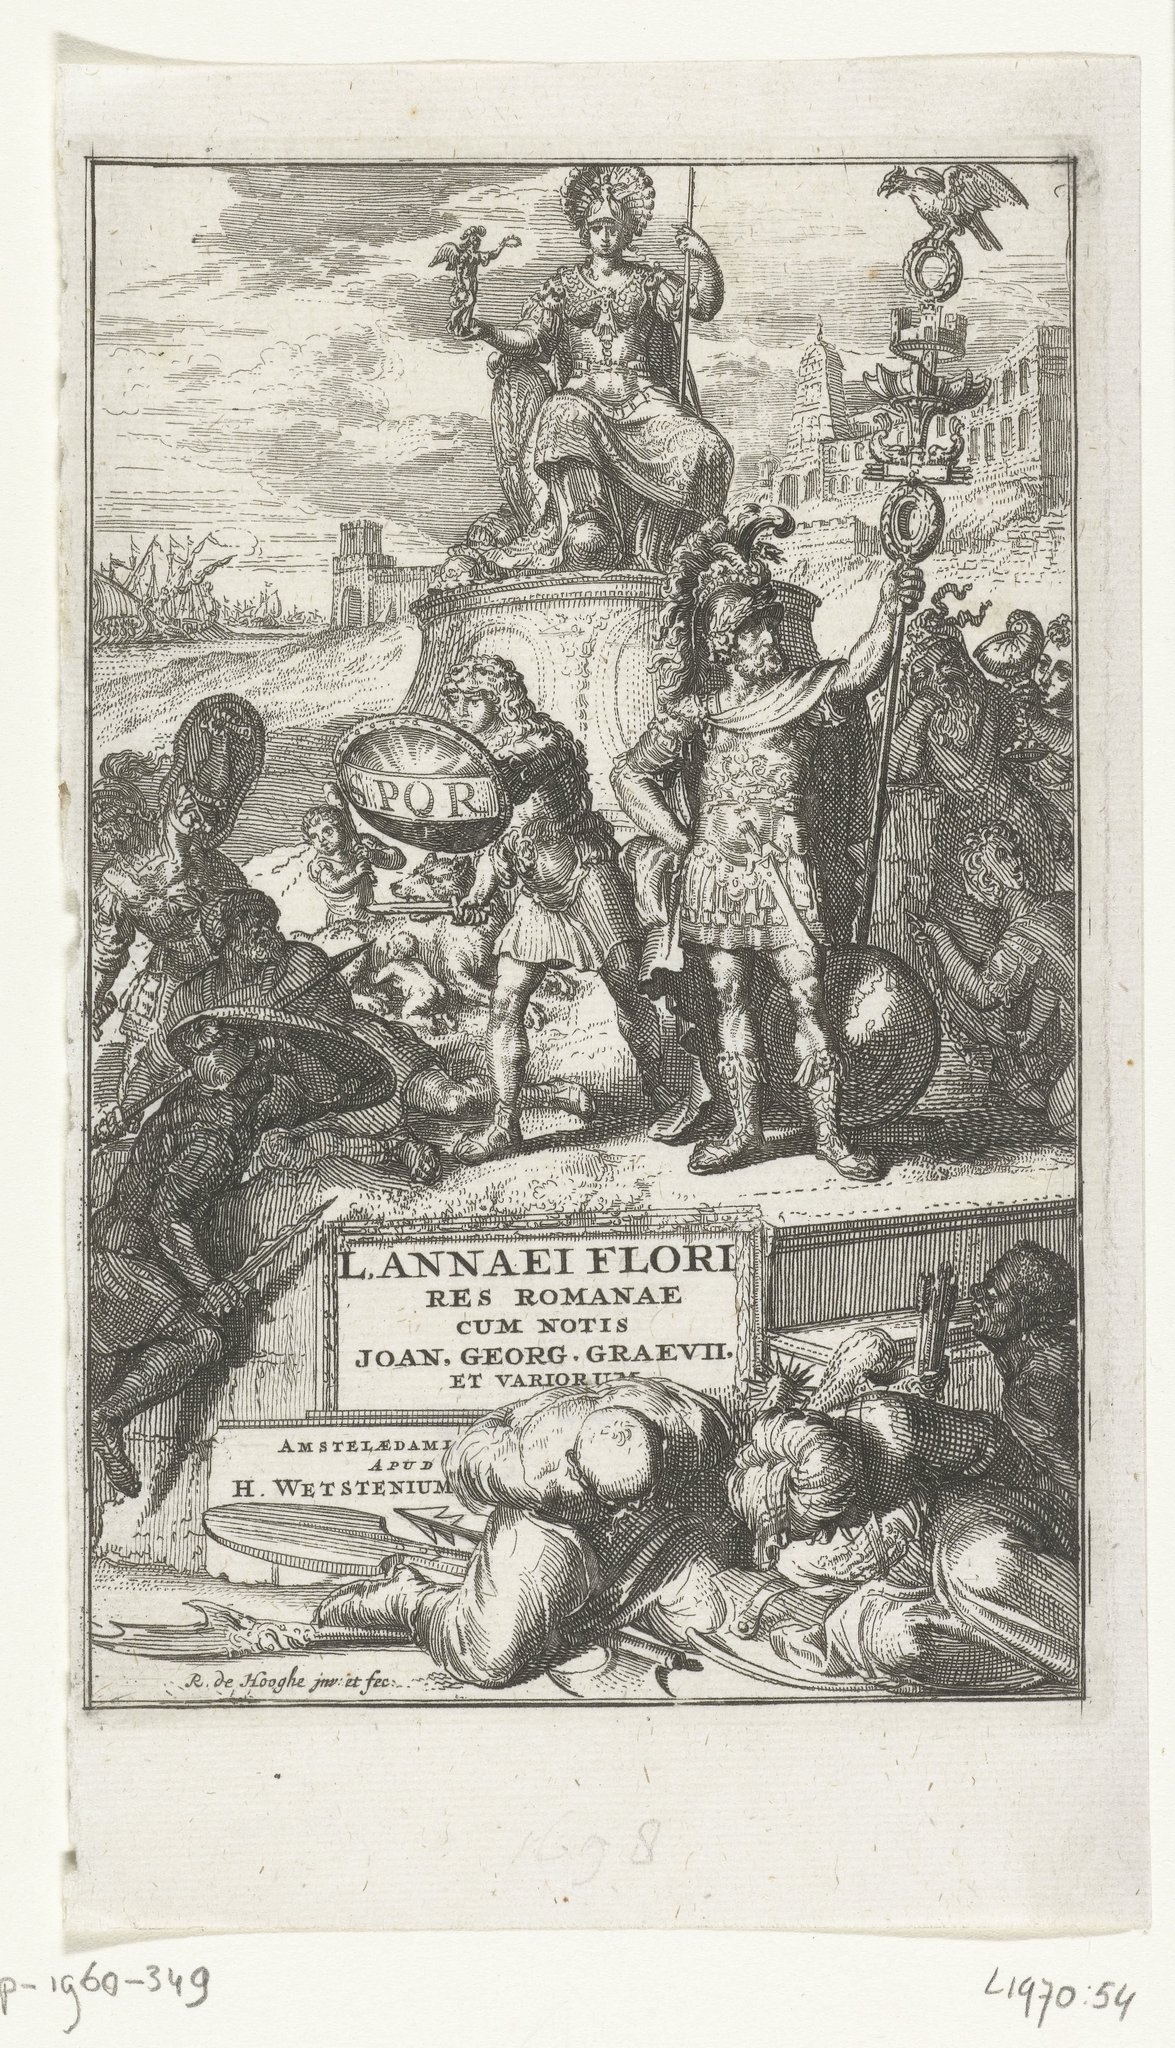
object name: titelprent, frontispice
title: Titelprent voor 'L. Annaeus Florus recensitus & illustratus a Joanne Georgio Grævio' van L. Annaeus Florus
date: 1680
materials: paper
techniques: engraving, etching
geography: amsterdam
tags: (story of) hercules (heracles), (story of) juno (hera), (story of) romulus and remus, (story of) janus, roman deities, and foreign deities included in the classical pantheon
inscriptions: collector's mark: Lugt 2228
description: Op een sokkel zit een Romeinse figuur (waarschijnlijk Juno) met een beeldje in de hand. Deze figuur is omringd door andere klassieke figuren, onder wie Romulus en Remus met de wolf, Hercules met zijn leeuwenvel en Janus met zijn twee gezichten herkenaar zijn.